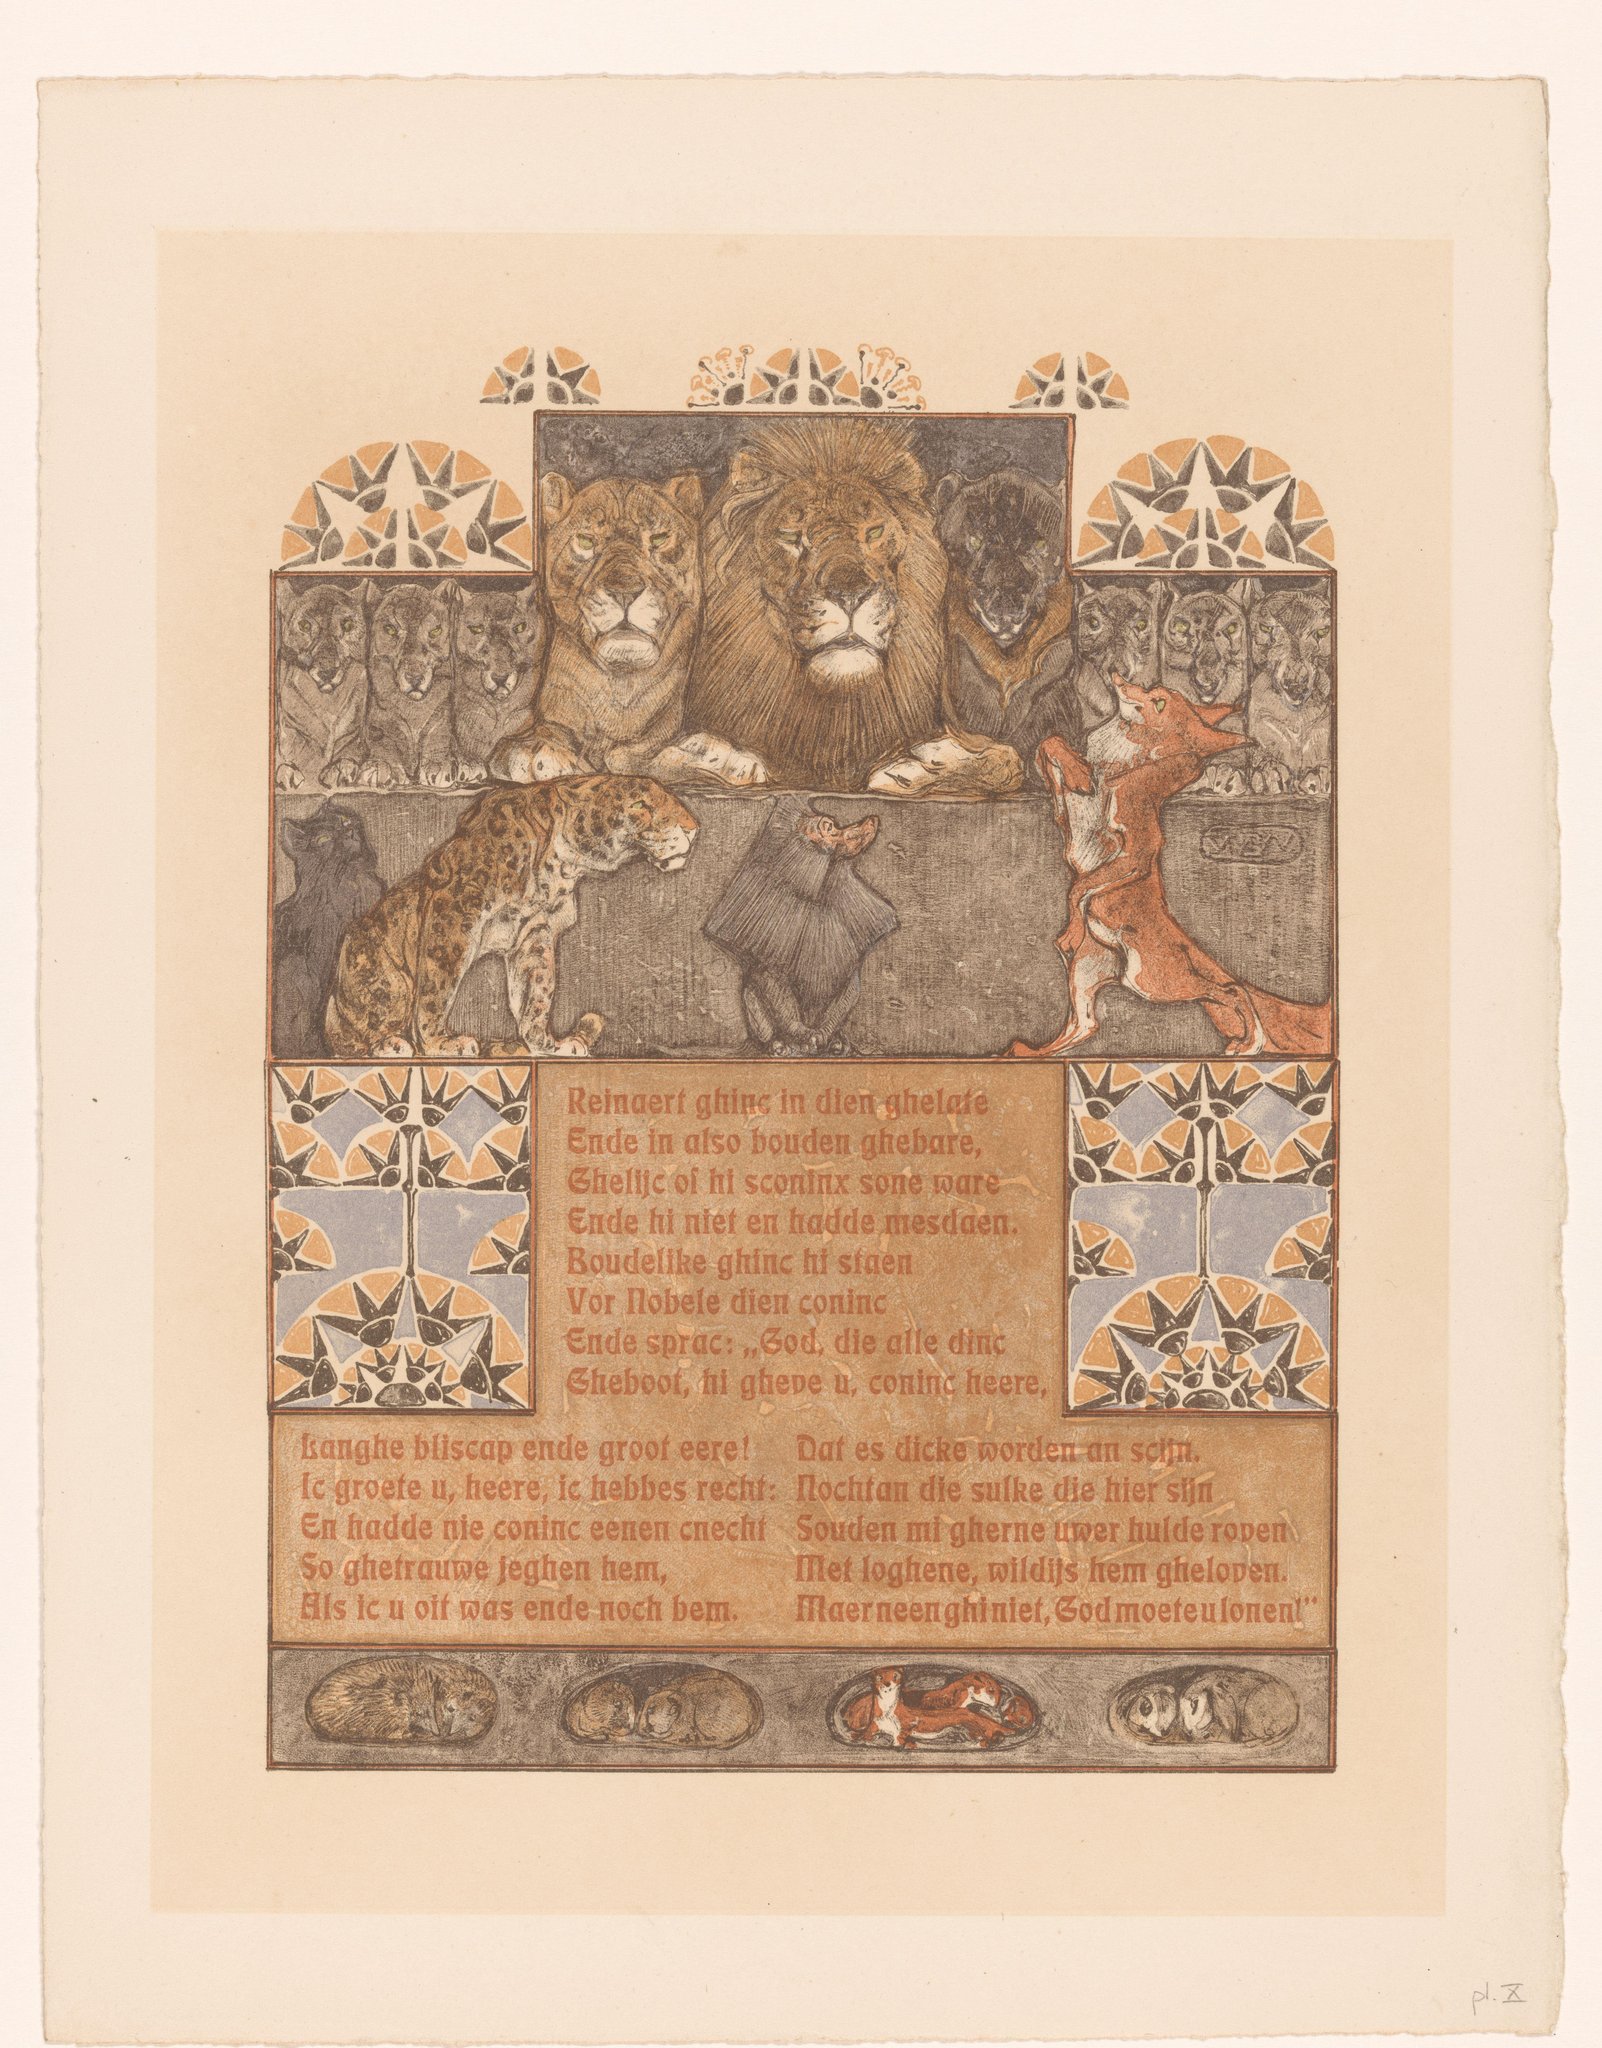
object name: book illustration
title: Vos (Reinaert) voor leeuw (Nobel) en andere dieren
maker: bernard willem wierink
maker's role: draughtsman, print maker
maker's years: 1856-1939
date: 1910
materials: paper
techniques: lithograph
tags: fable of reynard the fox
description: Prent gebruikt in: Streuvels, Stijn (Frank Lateur). Reinaert de Vos naar verschillende uitgaven van het middeleeuwsche epos. Amsterdam: L.J. Veen, 1910.